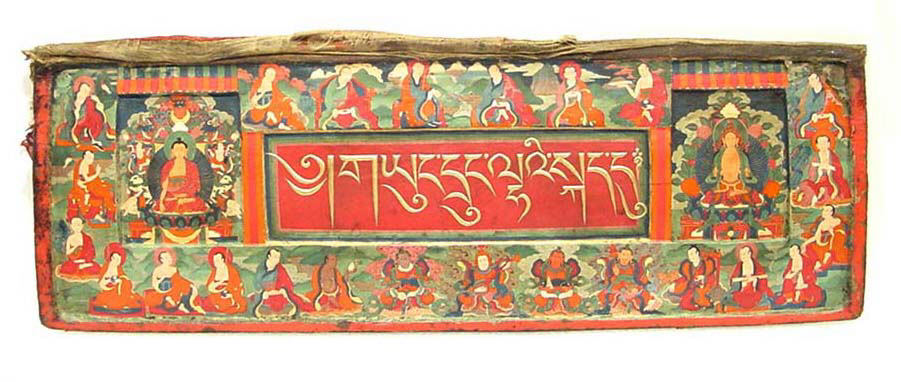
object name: folio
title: Opening Page of a Dispersed Manuscript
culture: tibetan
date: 1667-1700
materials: board, silk